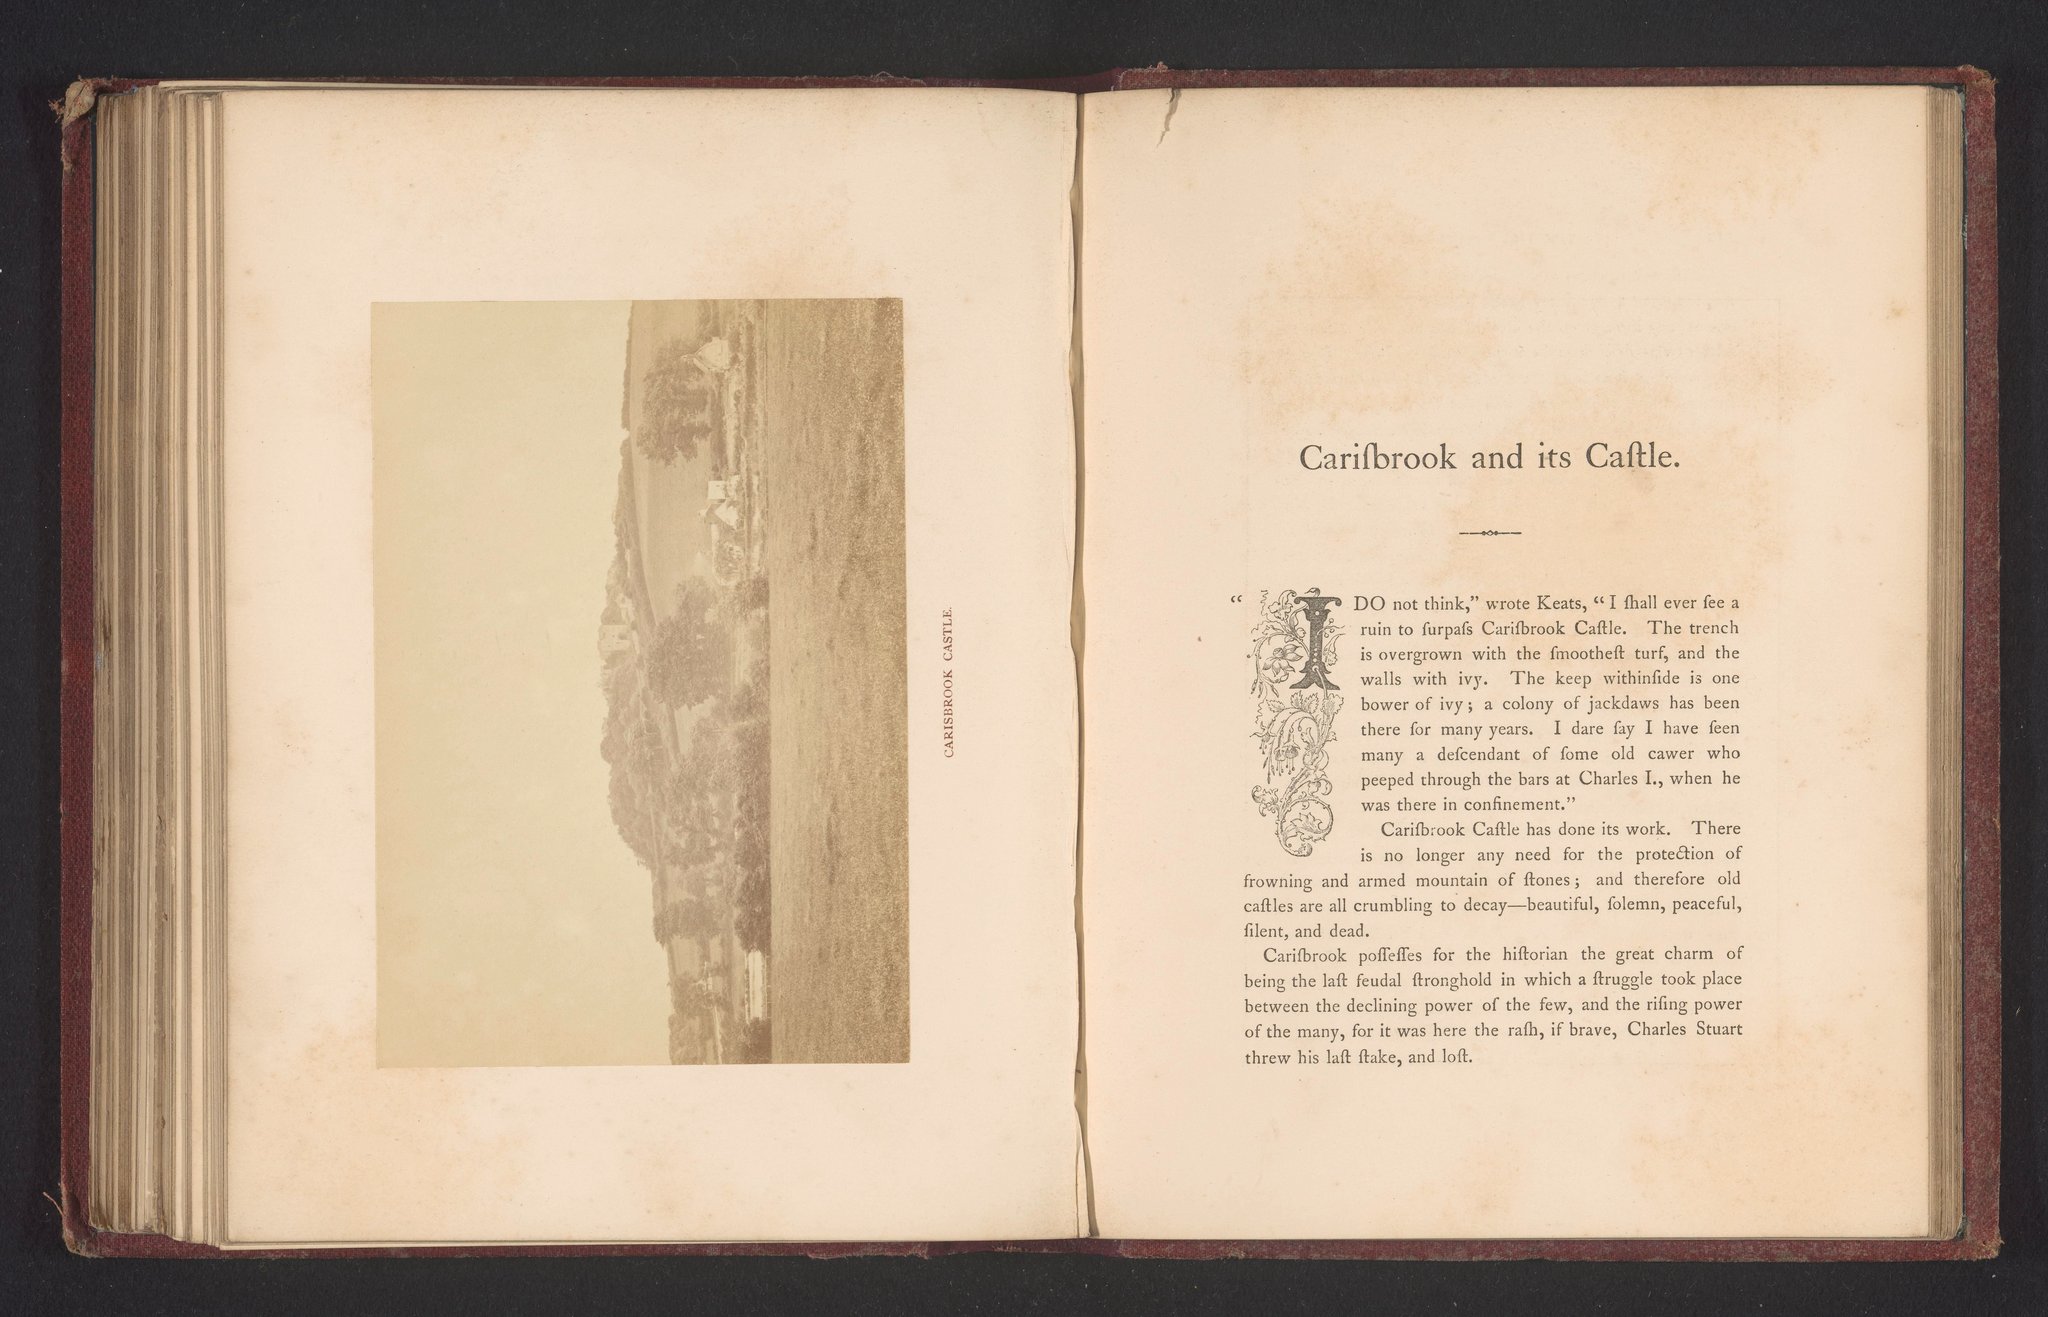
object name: photograph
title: Carisbrook Castle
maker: william russell sedgfield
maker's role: fotograaf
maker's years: 1826-1902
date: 1859-1869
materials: photographic support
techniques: albumen print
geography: isle of wight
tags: dale, valley, castle